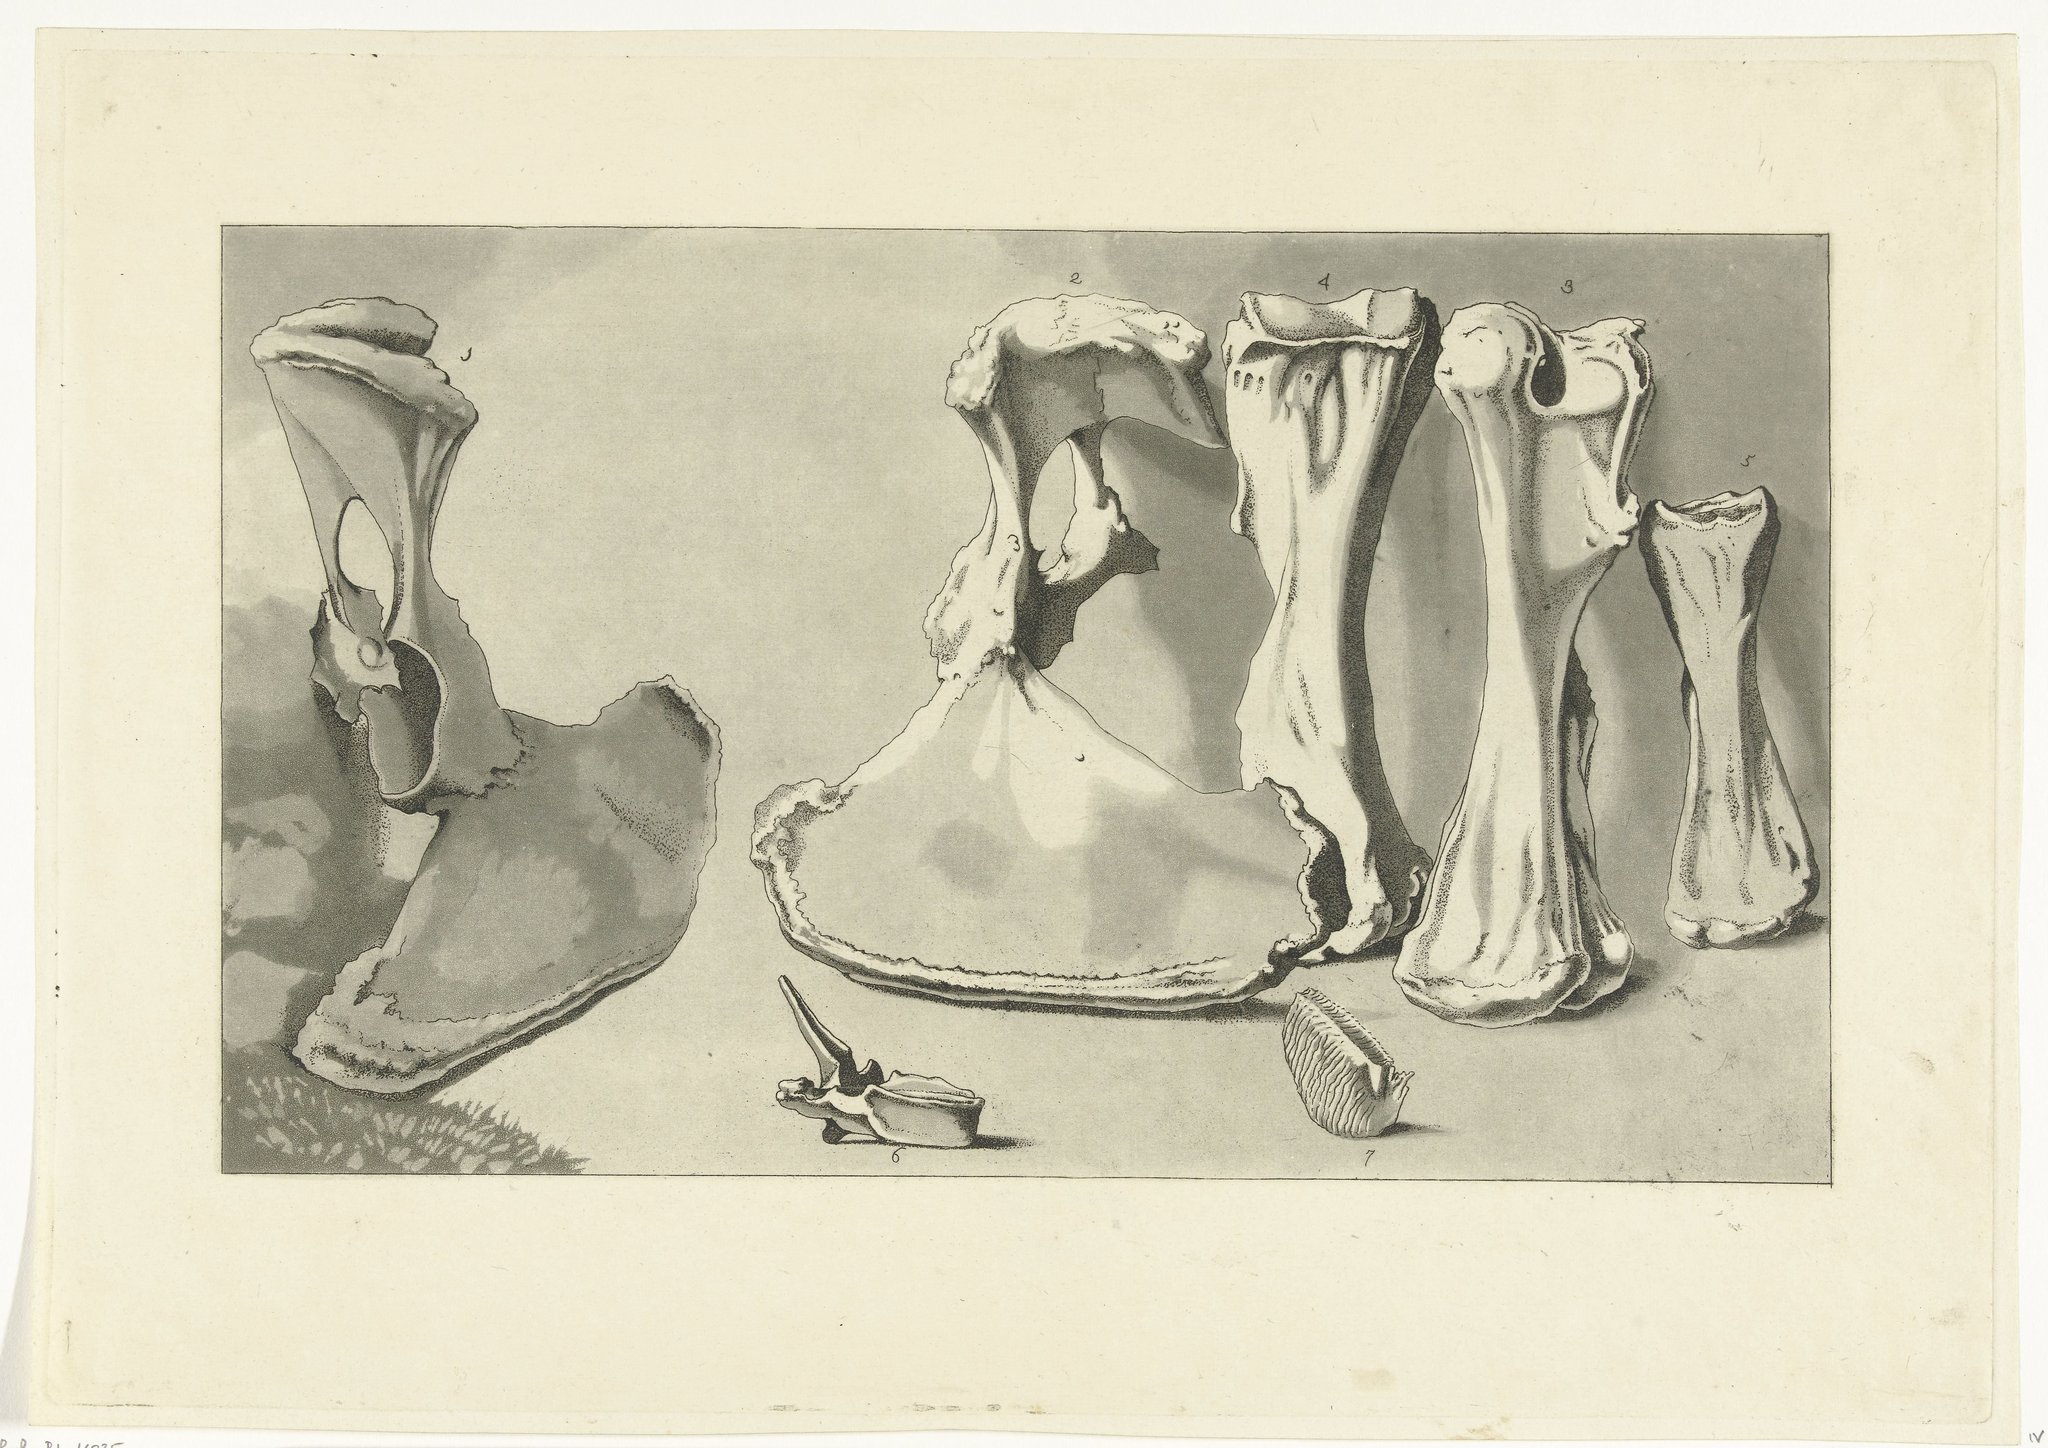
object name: print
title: Eenige beenderen by het doorbreken van den dyk by Loenen, door het water opgeworpen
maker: anthonie van den bos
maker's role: draughtsman, print maker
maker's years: 1763-1838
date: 1809-1810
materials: paper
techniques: aquatint, etching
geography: netherlands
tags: bones in general (human body), gelderland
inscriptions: collector's mark: Lugt 2228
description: Plaat gemaakt voor: H. Ewijk, Platen en kaarten behorende tot het geschiedkundig verslag der dijkbreuken en overstroomingen, langs de rivieren in het Koningrijk Holland, voorgevallen in louwmaand MDCCCIX. Amsterdam, J. Allart en J. Ruys, 1809.